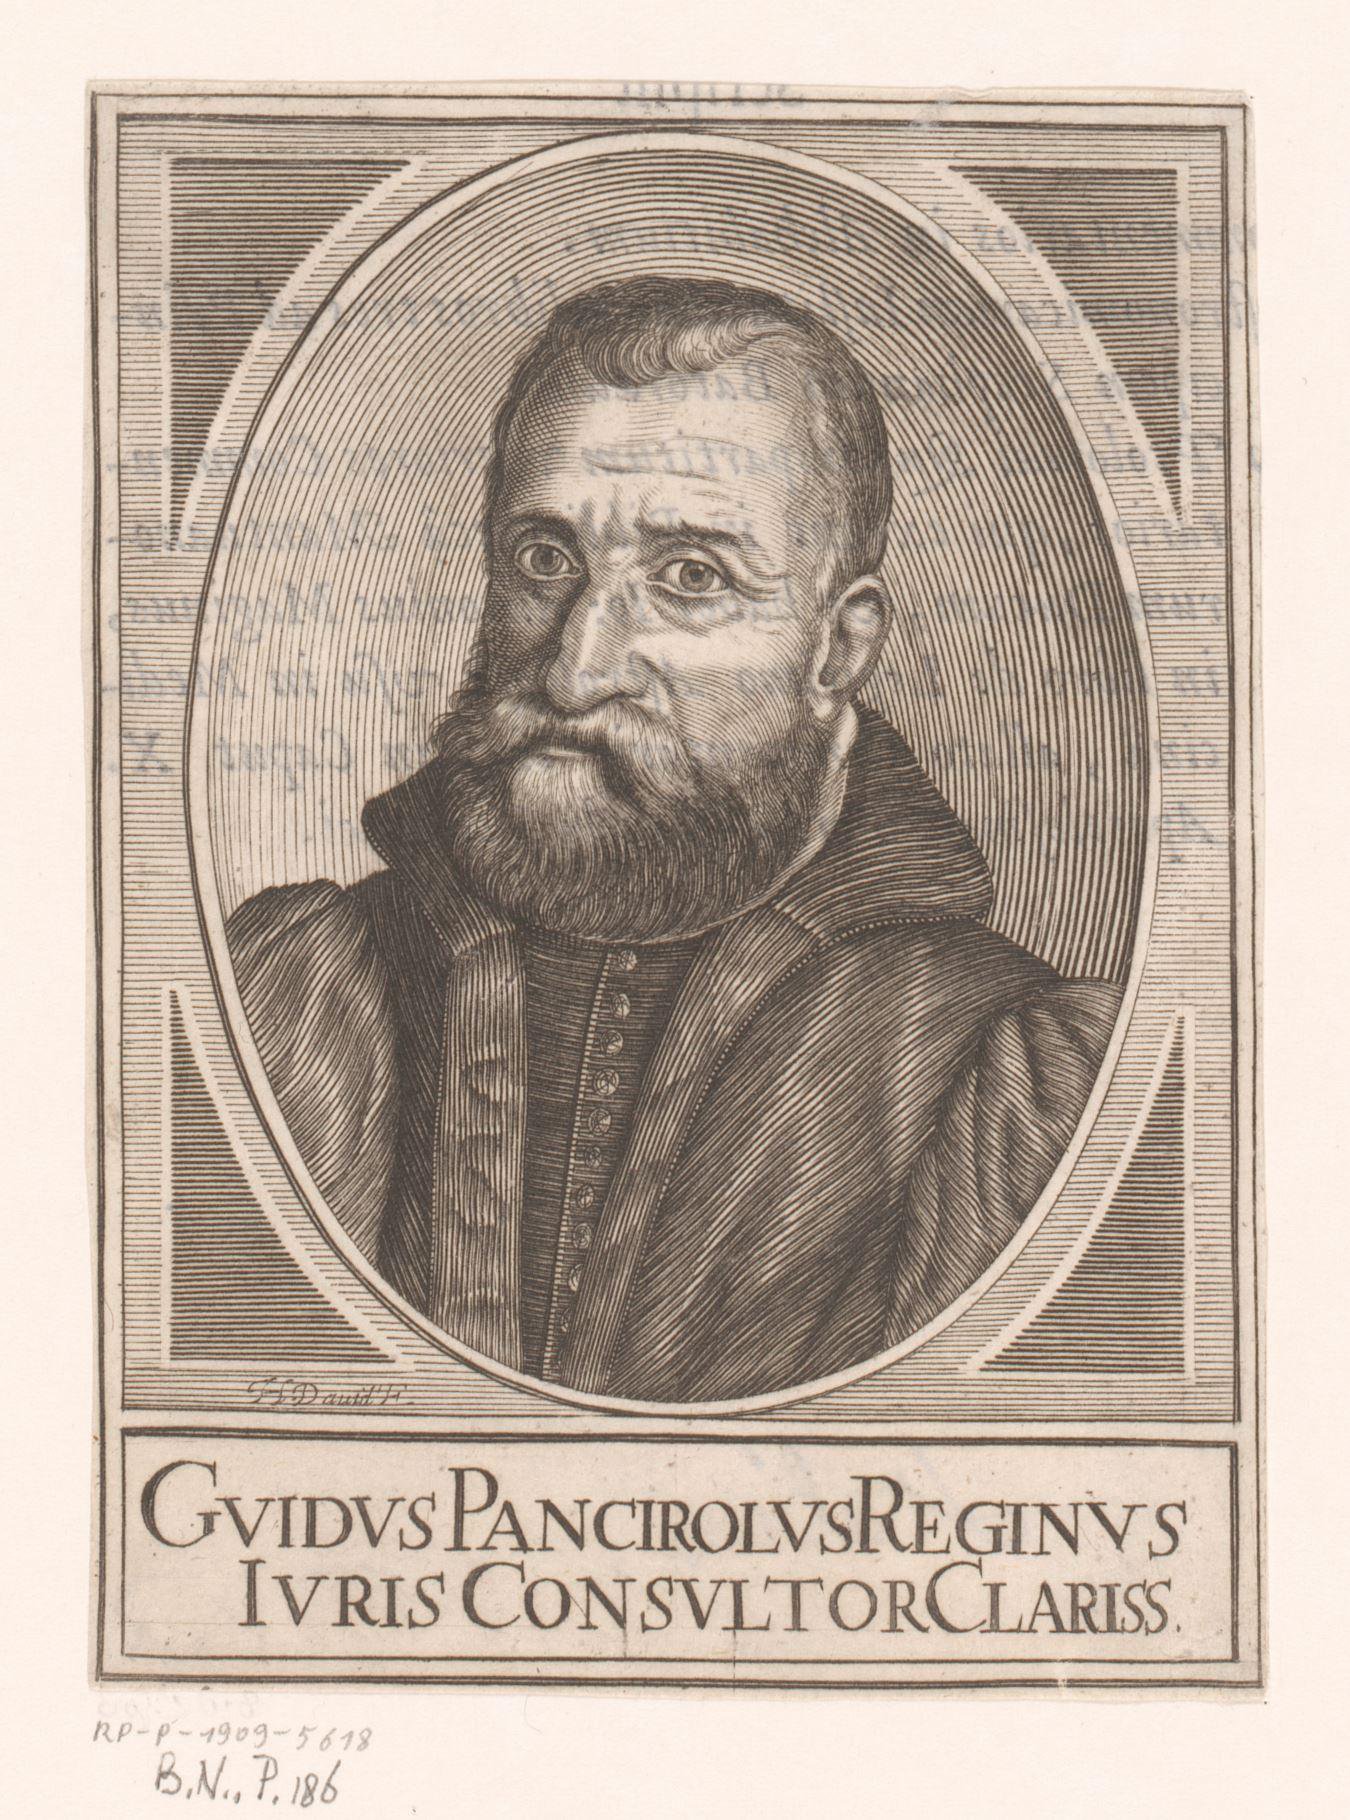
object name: book illustration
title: Guidus Pancirolus Reginus Ivris Consultor Clariss.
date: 1630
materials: paper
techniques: engraving, letterpress printing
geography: padua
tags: ornament ~ medallion, historical persons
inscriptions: collector's mark: Lugt 2228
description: Prent uit: Tomasini, Jacopo Filippo. Jacobi Philippi Tomasini Patavini Illustrium Virorum Elogia Iconibus Exornata (...). Padua: Donato Pasquardi, 1630, p. 186.